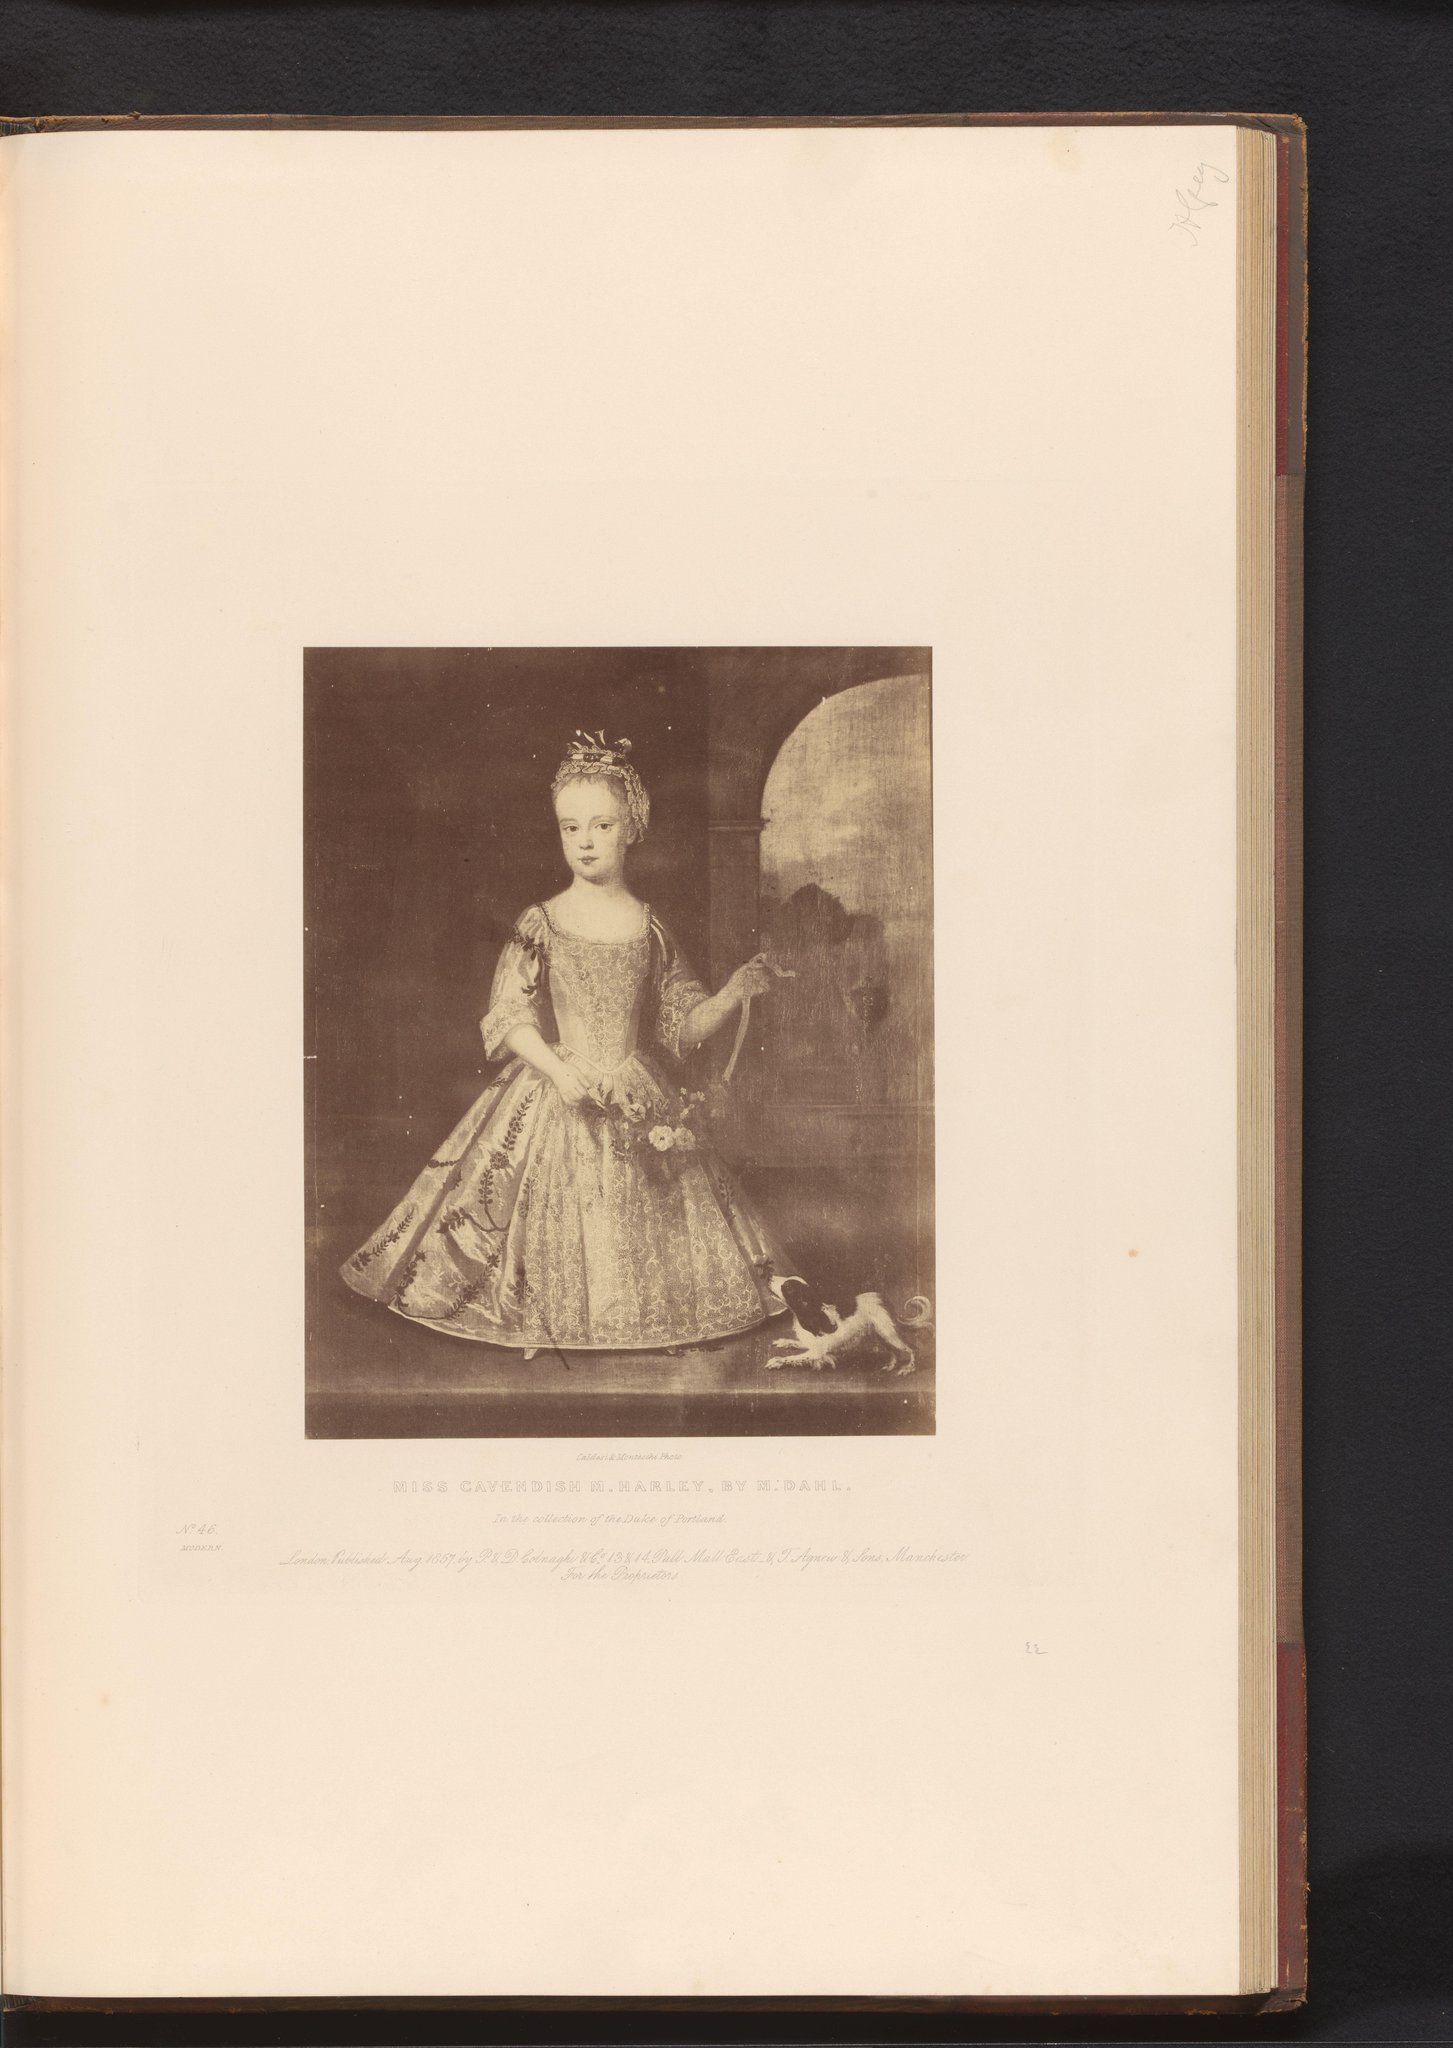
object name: page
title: Miss Cavendish M. Harley, by M. Dahl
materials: photographic support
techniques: albumen print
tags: historical persons - bb - woman, girl (child between toddler and youth)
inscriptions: number: ‘No. 46./ MODERN.’, inscription: ‘In the Collection of The Duke of Portland./ London, Published Aug, 1857, by P. & D. Colnaghi & Co, 13 & 14, Pall Mall East & T. Agneur & Sons, Manchester./ For the Proprietors.’, number: ‘22’